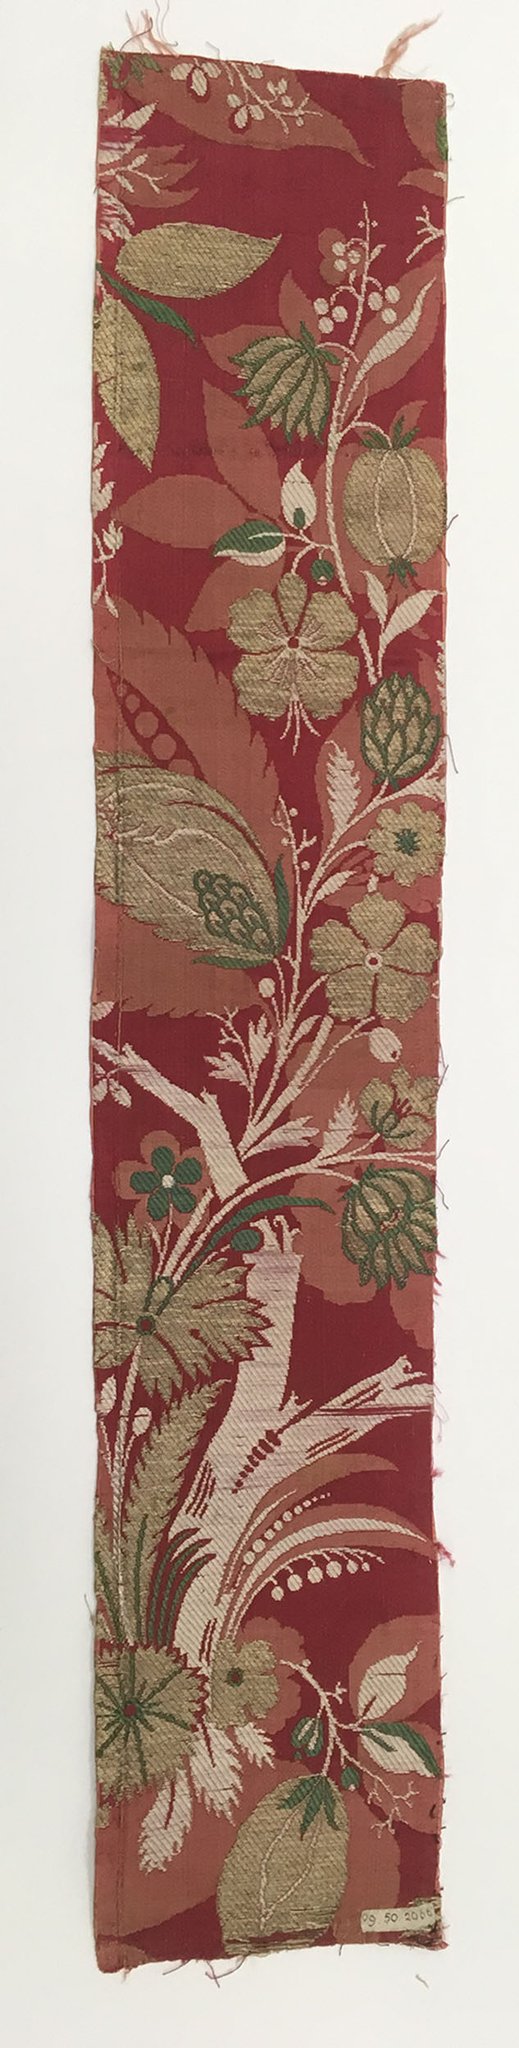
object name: piece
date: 1730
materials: metal thread, silk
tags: flowers,leaves